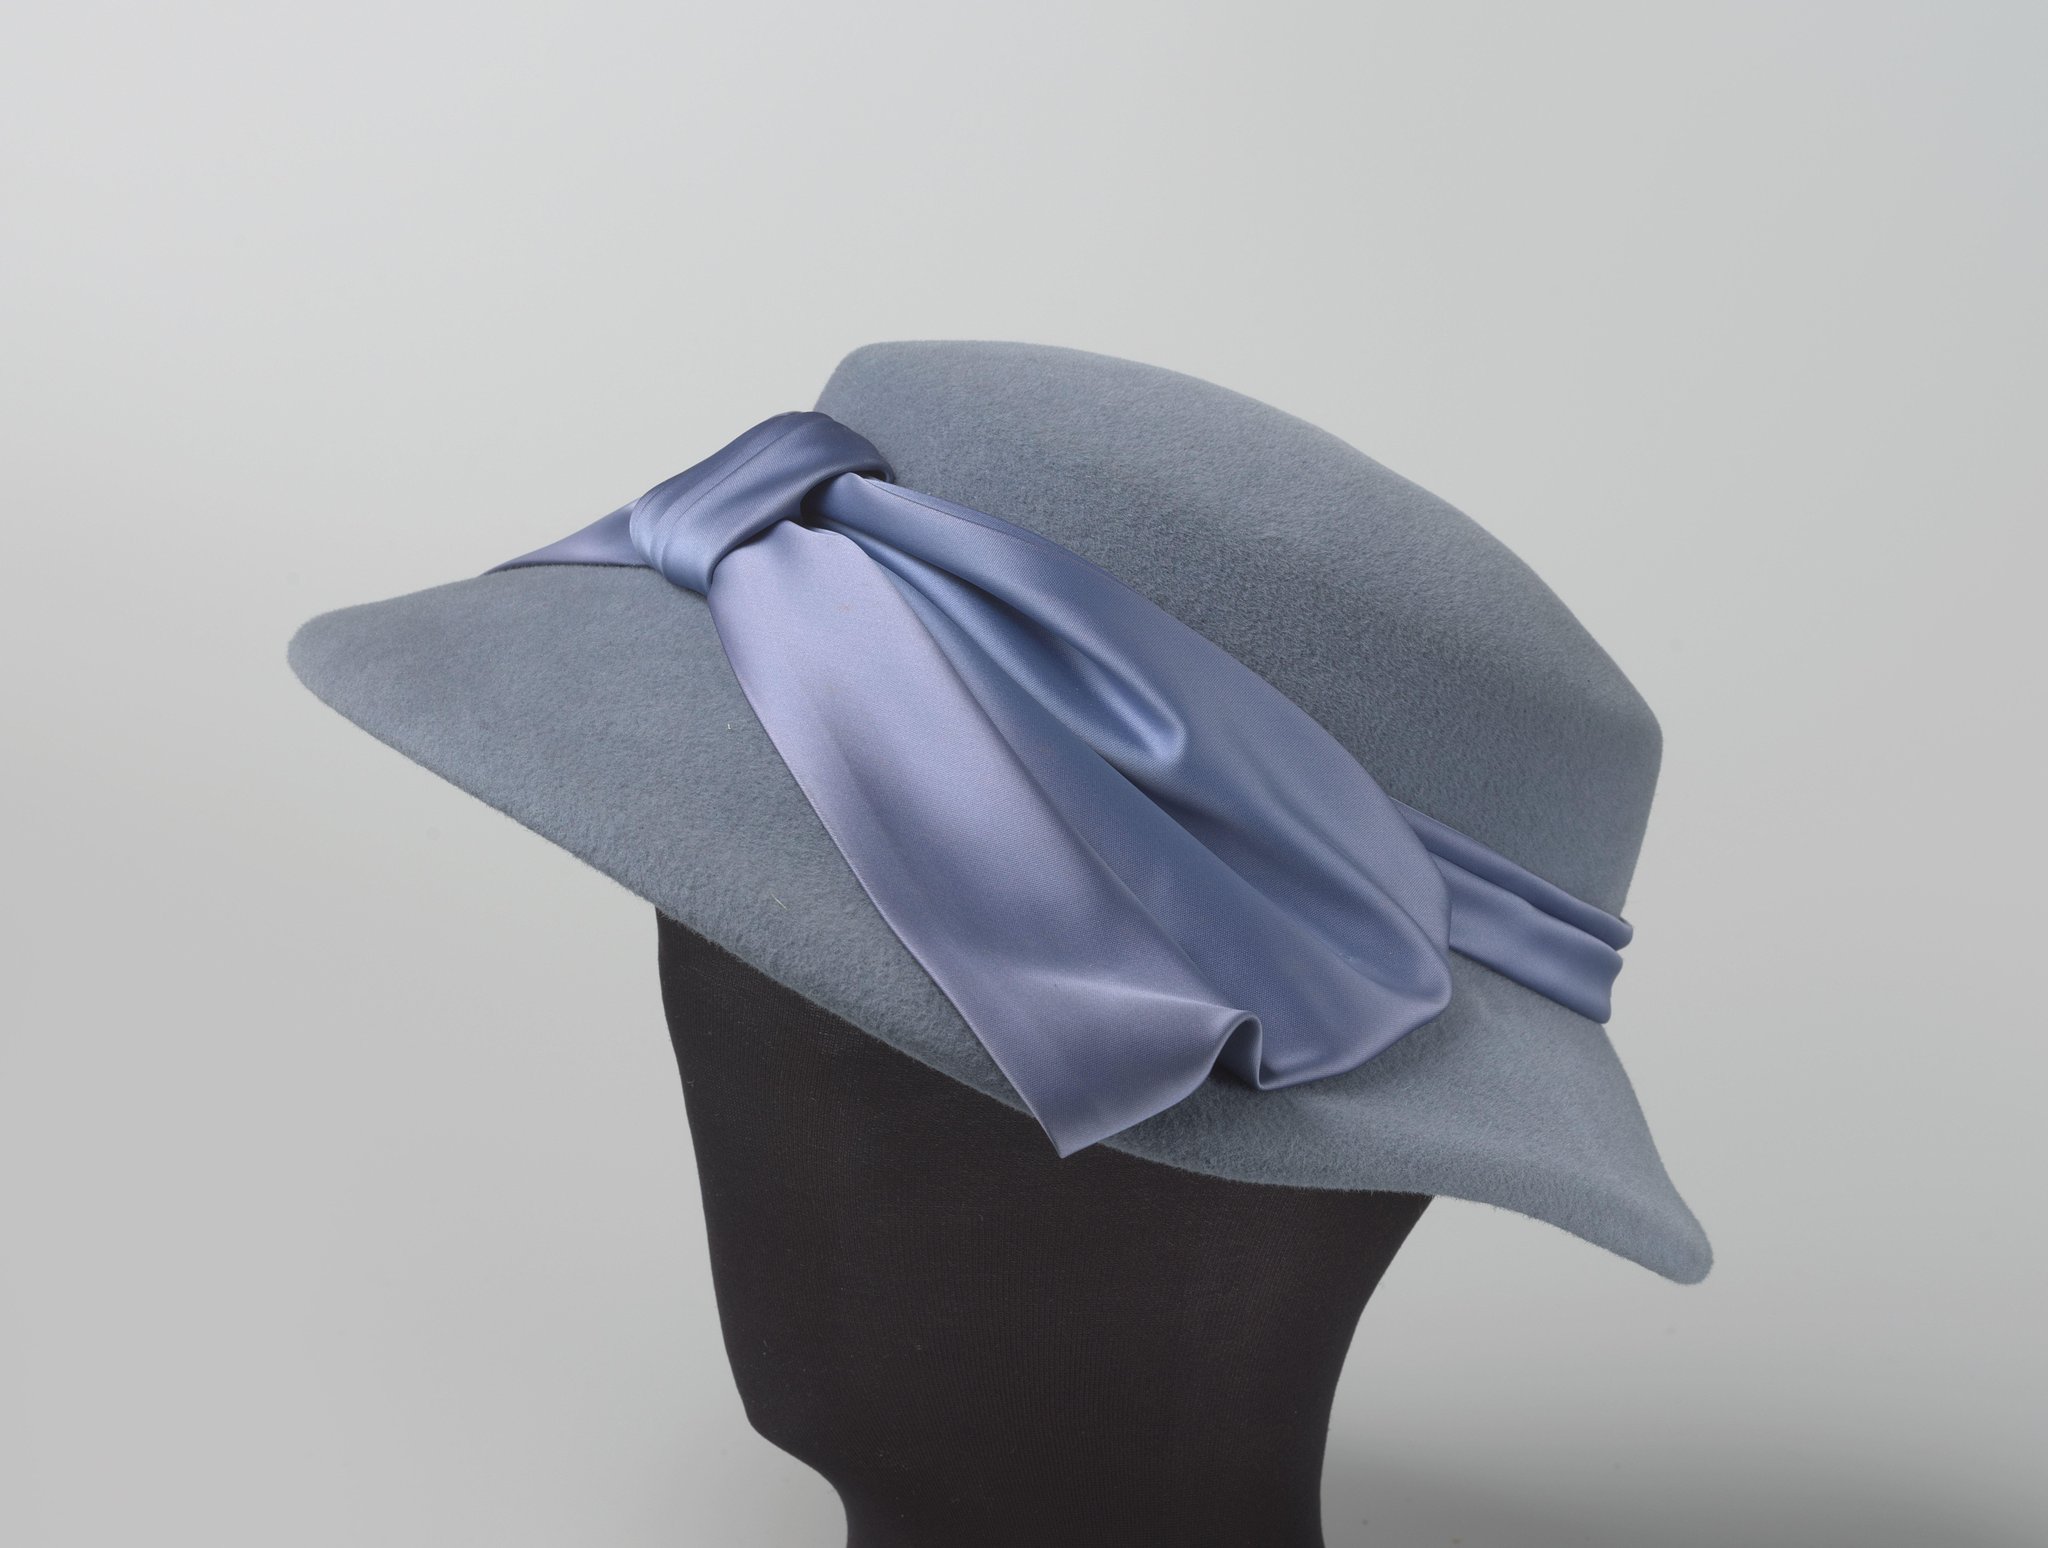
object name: womenswear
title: Hoed van lichtblauw vilt, met strik van satijn opgemaakt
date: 1950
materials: felt, textile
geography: california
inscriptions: label: ‘CHARLES // OF // CALIFORNIA’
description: Hoed van lichtblauw vilt, met strik van satijn opgemaakt. Model: Vrij lage bol, met een bodemknik, een brede neerhangende rand, van voren breder dan van achter. Metalen versteviging in de rand die is ingeslagen en afgeboord. Rondom de bol een ingeplooide reep lichtblauw satijn en van voren twee grote, vastgehechte striklussen van satijn.